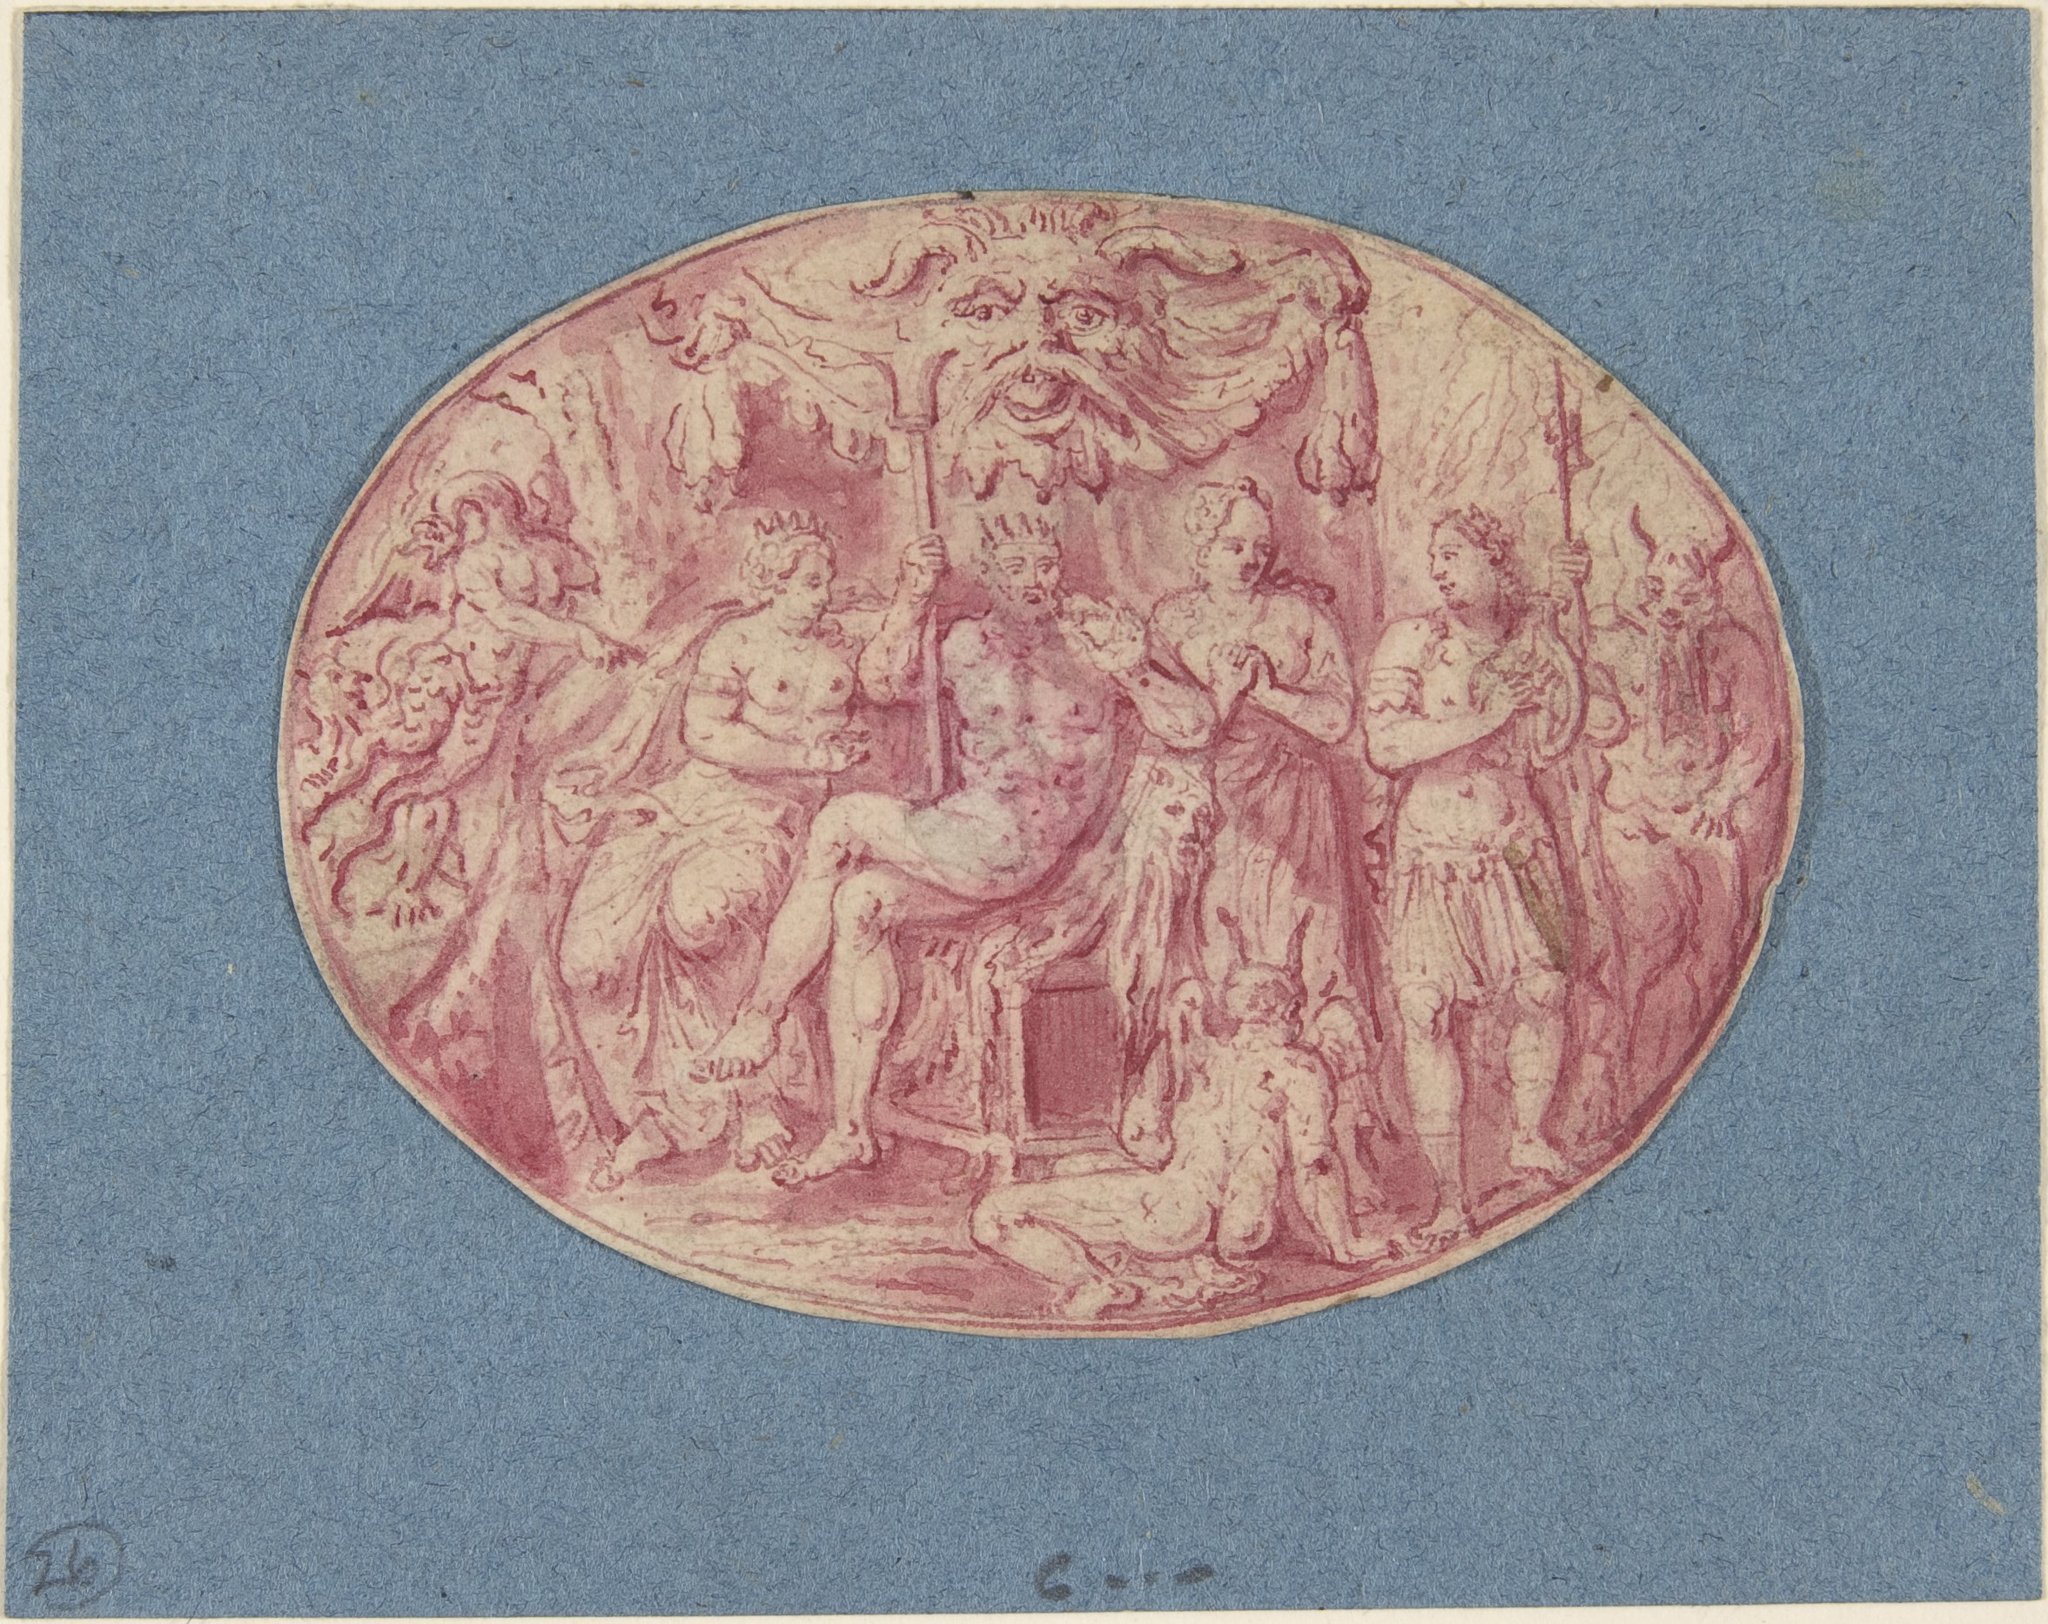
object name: drawing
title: Ornamental design with Orpheus and Eurydice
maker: anonymous, dutch, 17th century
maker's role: artist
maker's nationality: dutch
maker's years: 1600-1700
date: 1601-1700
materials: ink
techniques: brush, pen, wash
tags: male nudes,women,female nudes,orpheus,eurydice